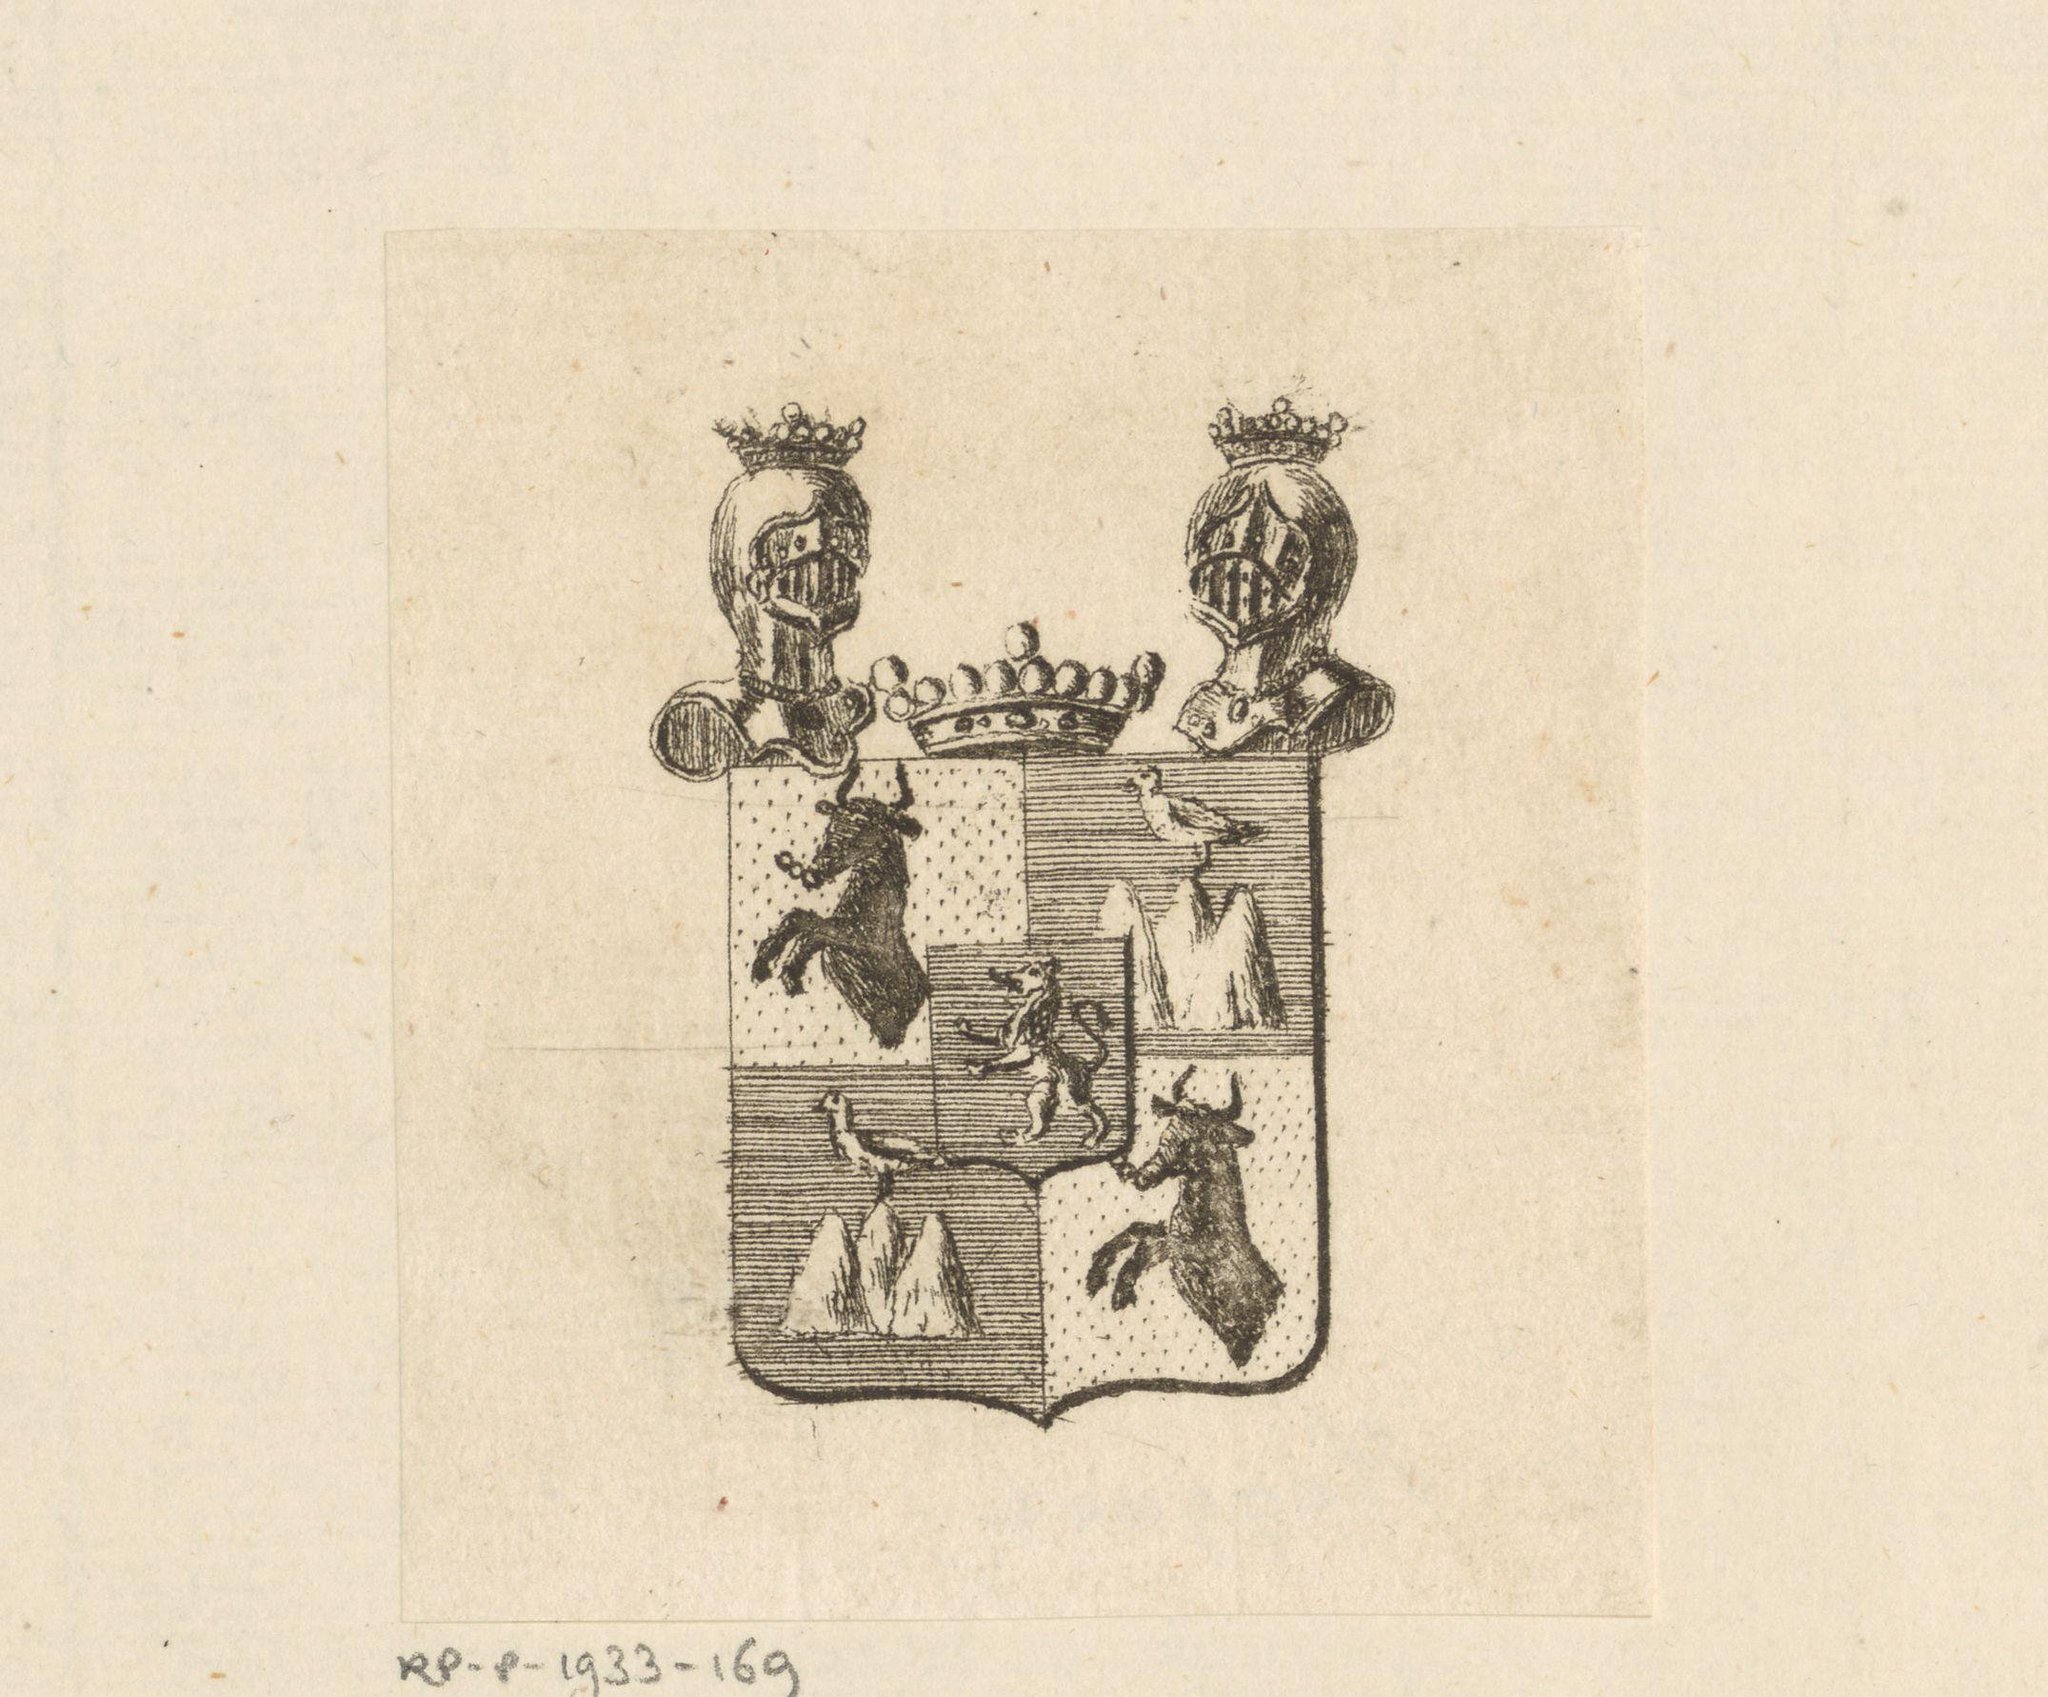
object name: bookplate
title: Ex libris van Hoqquer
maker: Anonymous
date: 1700-1799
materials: paper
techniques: etching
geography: netherlands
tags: bull, birds, armorial bearing, heraldry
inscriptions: collector's mark: Lugt 2233, collector's mark: Lugt 2760